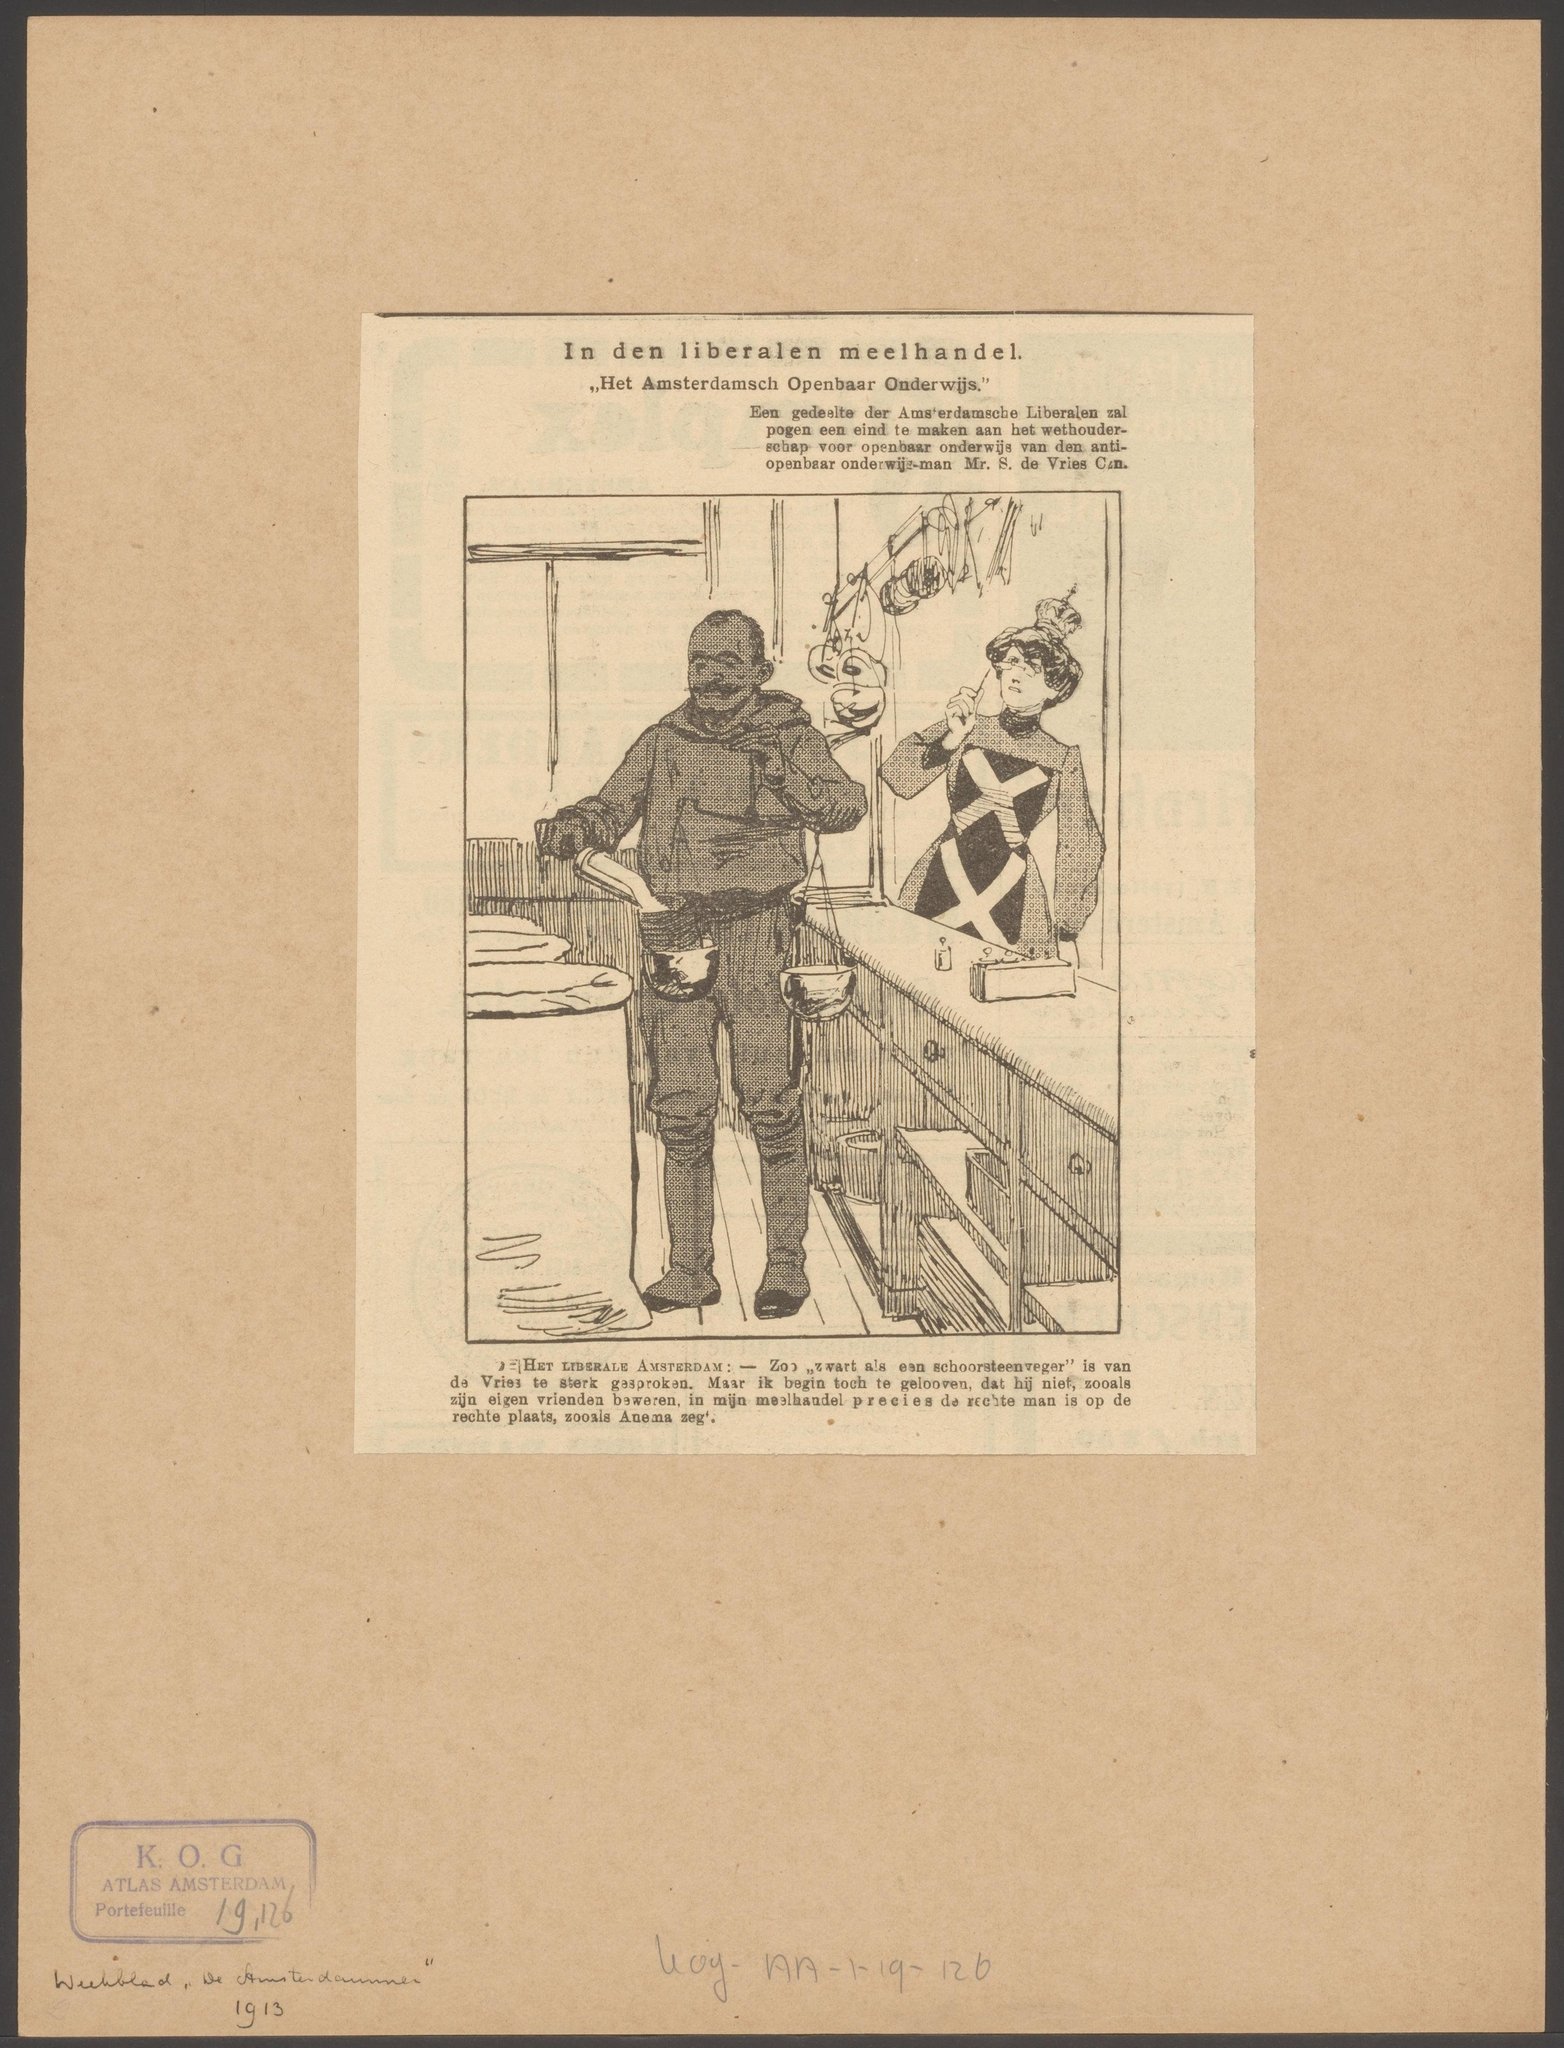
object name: cartoon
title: In den liberalen meelhandel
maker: Anonymous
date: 1913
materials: paper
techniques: letterpress printing, line block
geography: amsterdam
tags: politician, politician, e.g. party leader, political caricatures and satires, amsterdam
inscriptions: collector's mark: ‘19,126’ Lugt 1641b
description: Onderwerpsrubriek binnen de Atlas Amsterdam: Herinneringen aan regeringsleden en hunne huisgezinnen [na 1800].